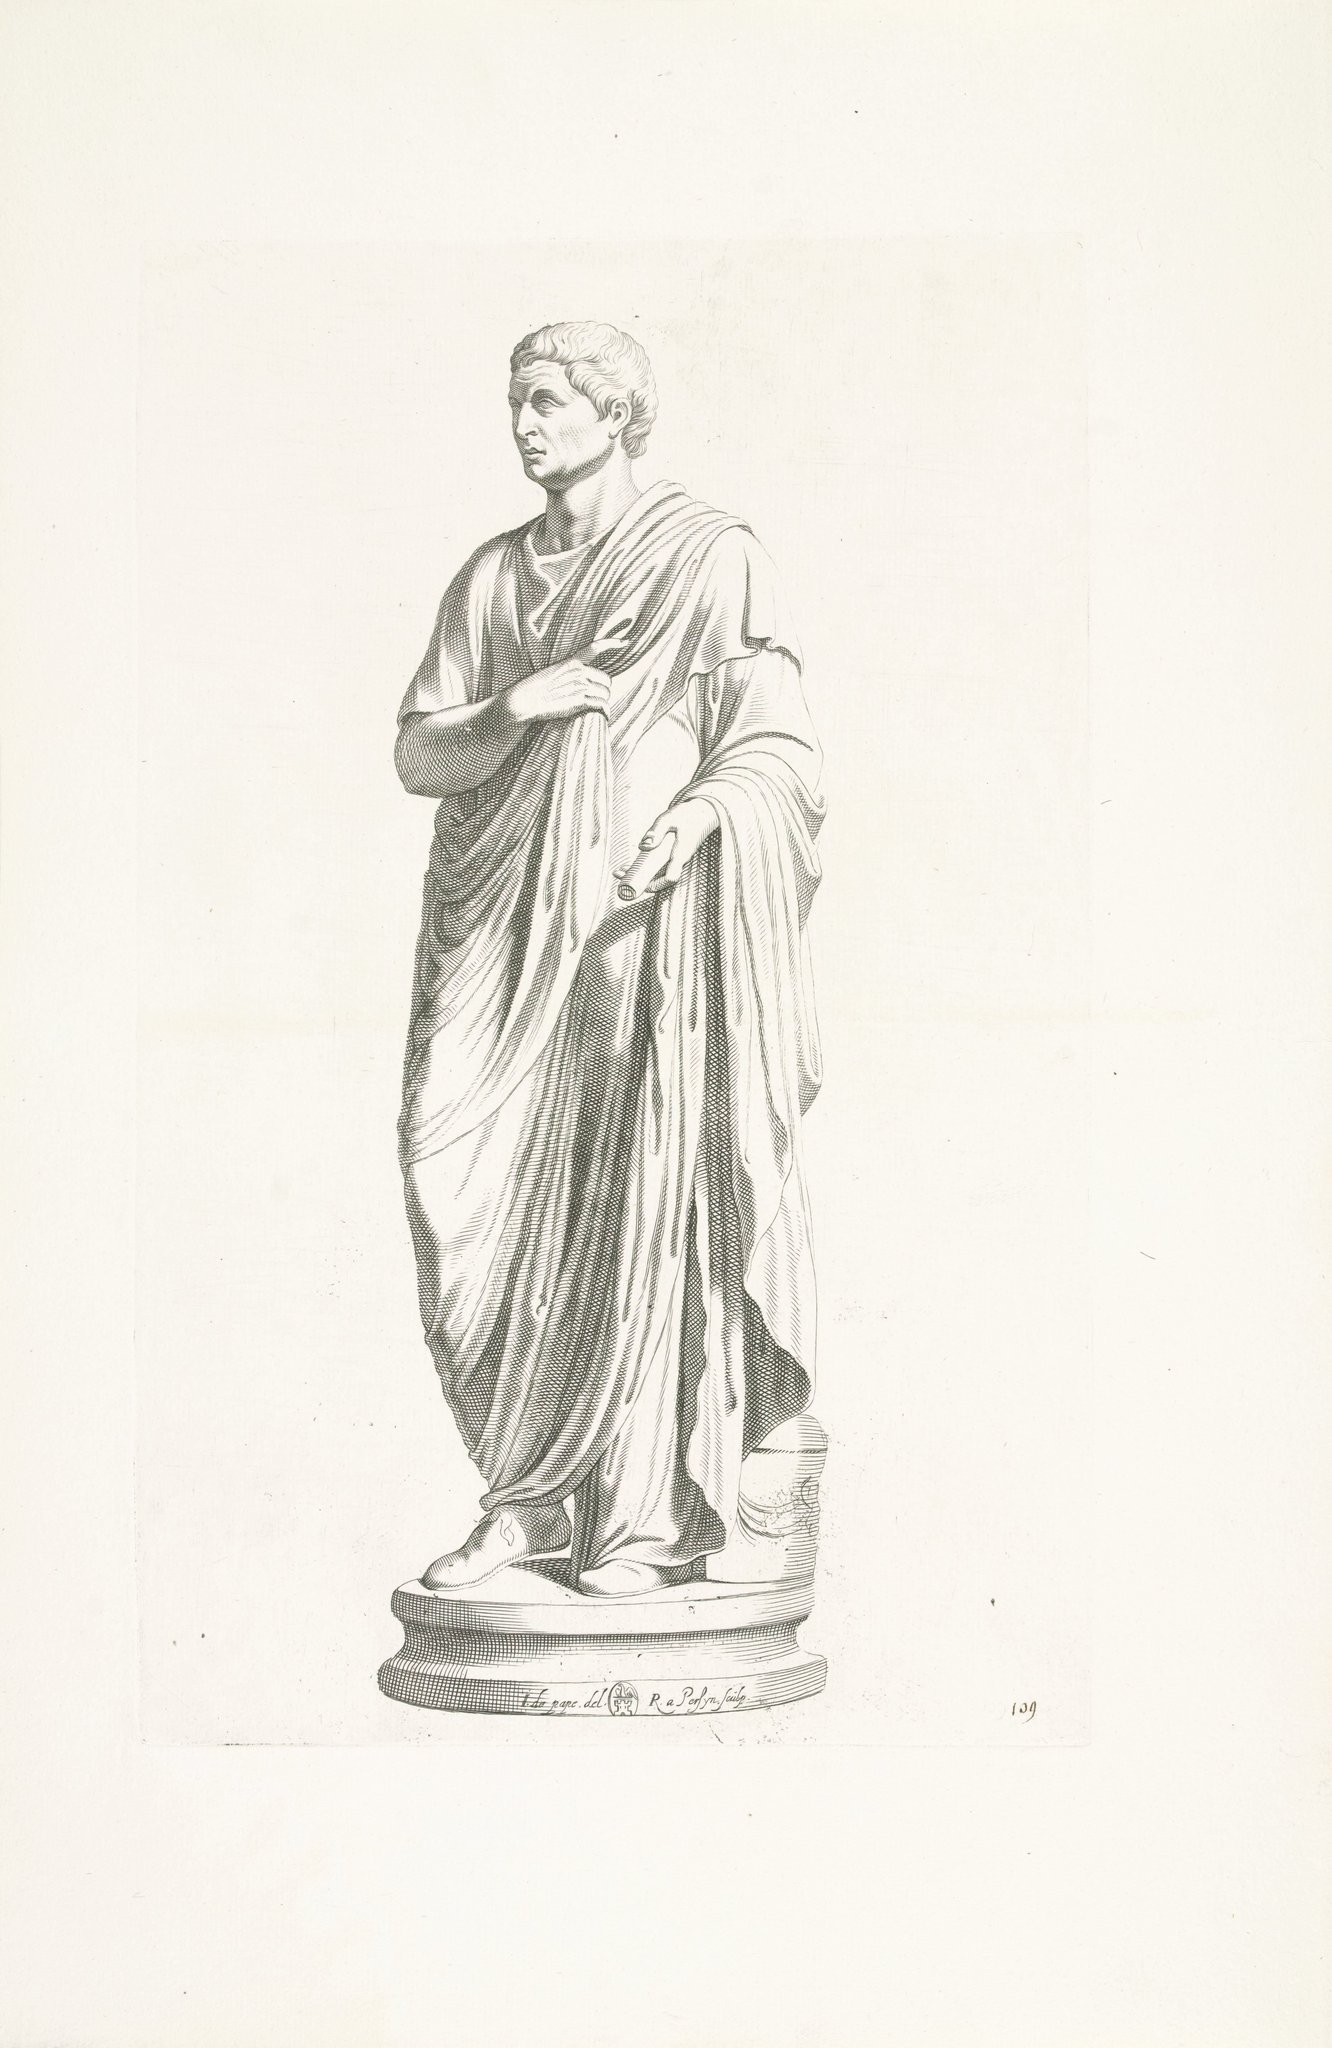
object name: print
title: Galleria Giustiniana del Marchese Vincenzo Giustiniani I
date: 1640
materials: paper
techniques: engraving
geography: rome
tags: vincenzo giustiniani (1564-1637), scholar, philosopher, piece of sculpture, reproduction of a piece of sculpture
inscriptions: collector's mark: Lugt 2228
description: Standbeeld van een consul, in klassiek gewaad, met een rol papier in de hand. Midden onder op de basis het wapenschild van Vincenzo Giustiniani. Prent uit een publicatie met reproductieprenten naar de sculpturen in de verzameling in de Galleria Giustiniani te Rome.